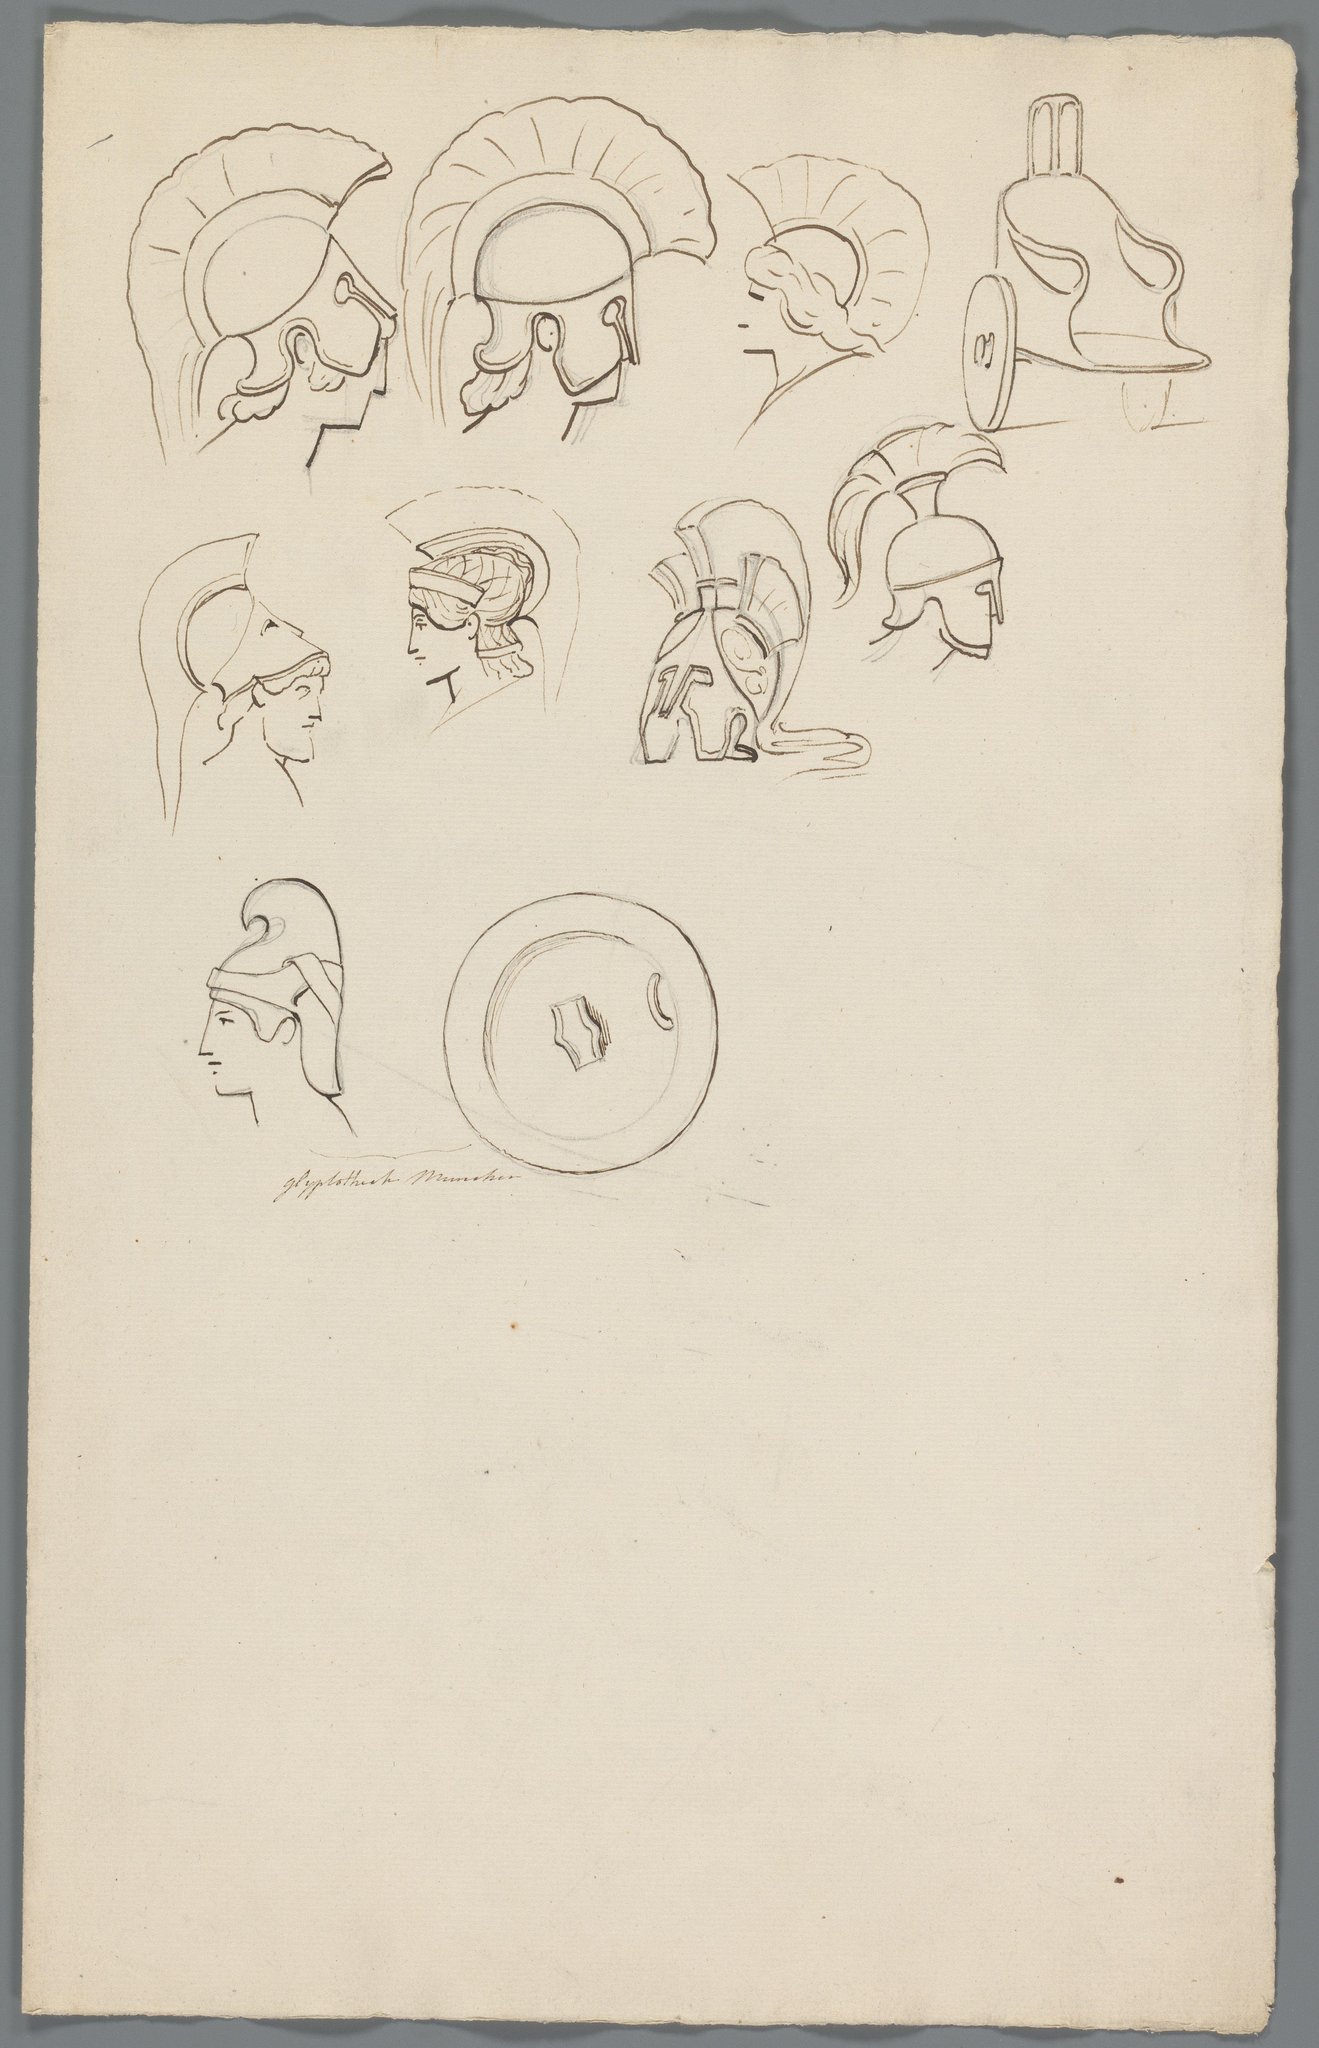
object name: drawing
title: Romeinse helmen, een strijdwagen en een schild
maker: jacobus everhardus josephus van den berg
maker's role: draughtsman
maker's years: 1802-1861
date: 1812-1861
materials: ink, paper, pencil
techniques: pen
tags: helmet, protective weapons: shield, chariot, triumphal car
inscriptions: inscription: ‘Glyptothek München’